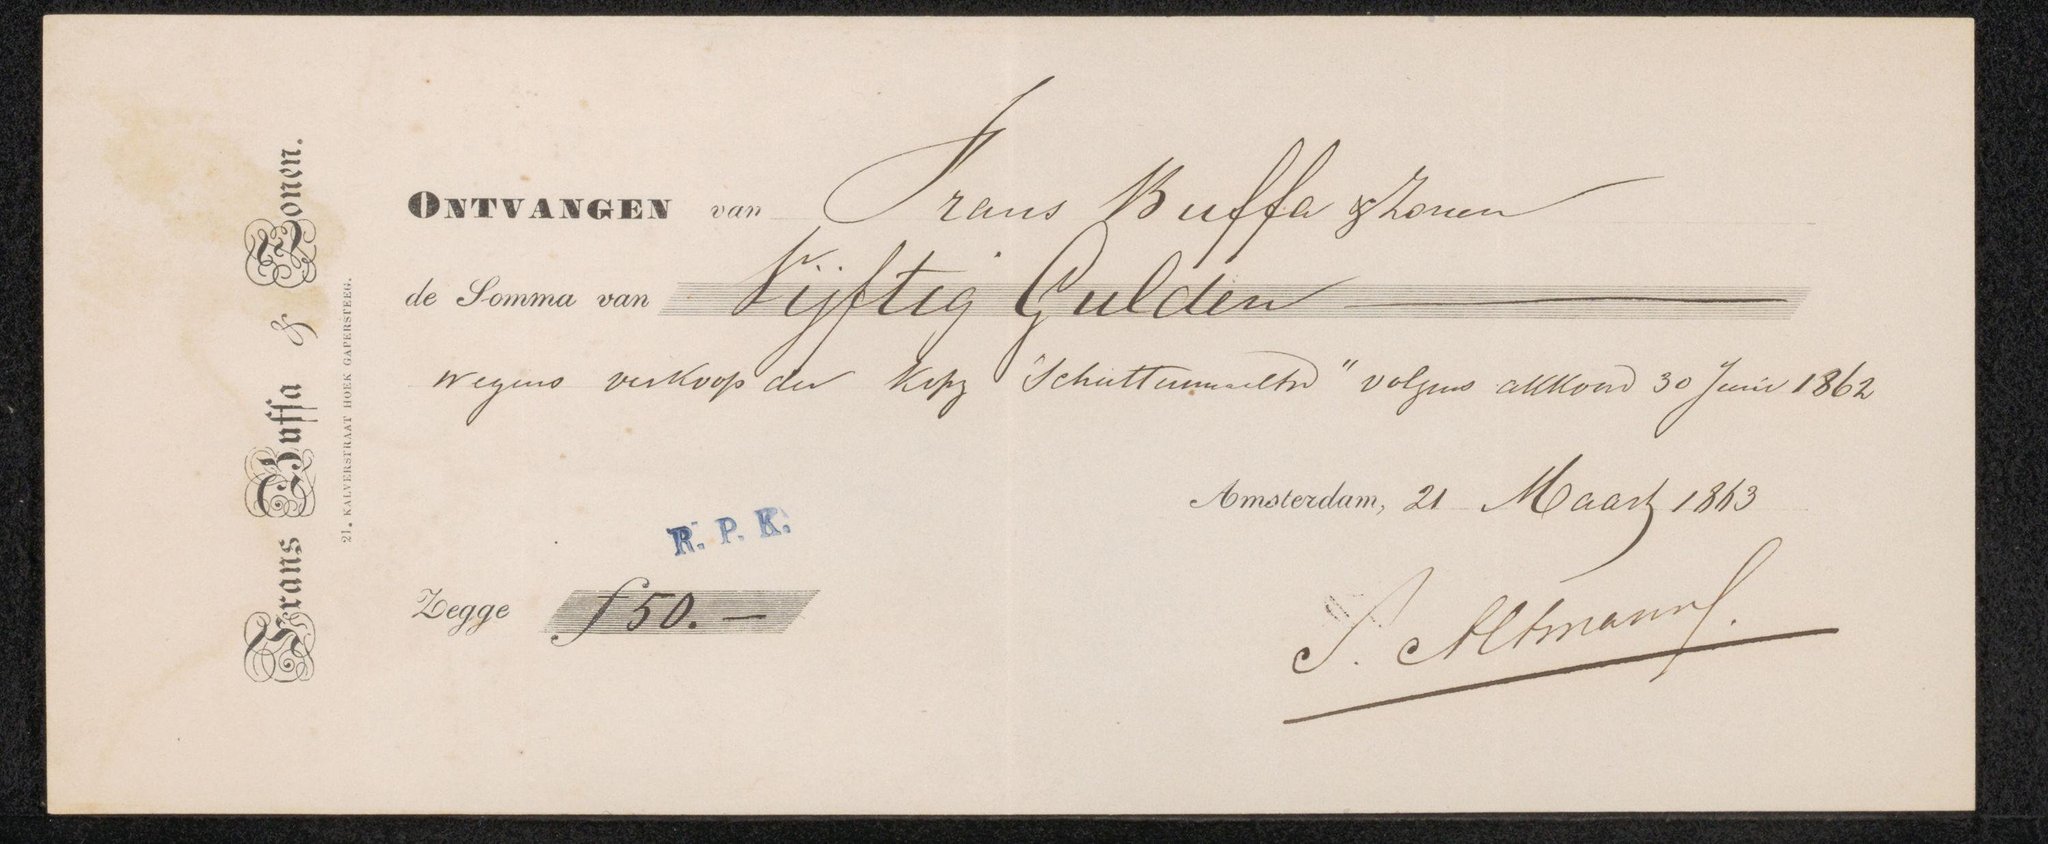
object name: ontvangstbewijs, kwitantie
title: Kwitantie voor Sybrand Altmann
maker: s. altmann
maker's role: painter, print maker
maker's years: 1822-1890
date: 1863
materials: ink, paper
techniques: pen, printing, writing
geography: amsterdam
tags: painting (including book-illumination, miniature-painting), money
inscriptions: collector's mark: Lugt 2233